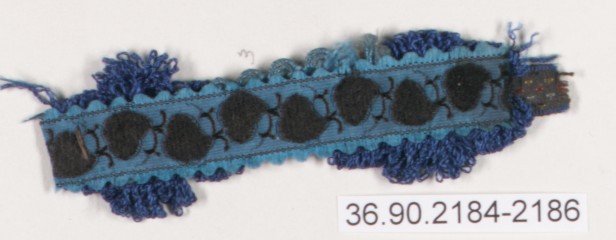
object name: piece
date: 1801-1900